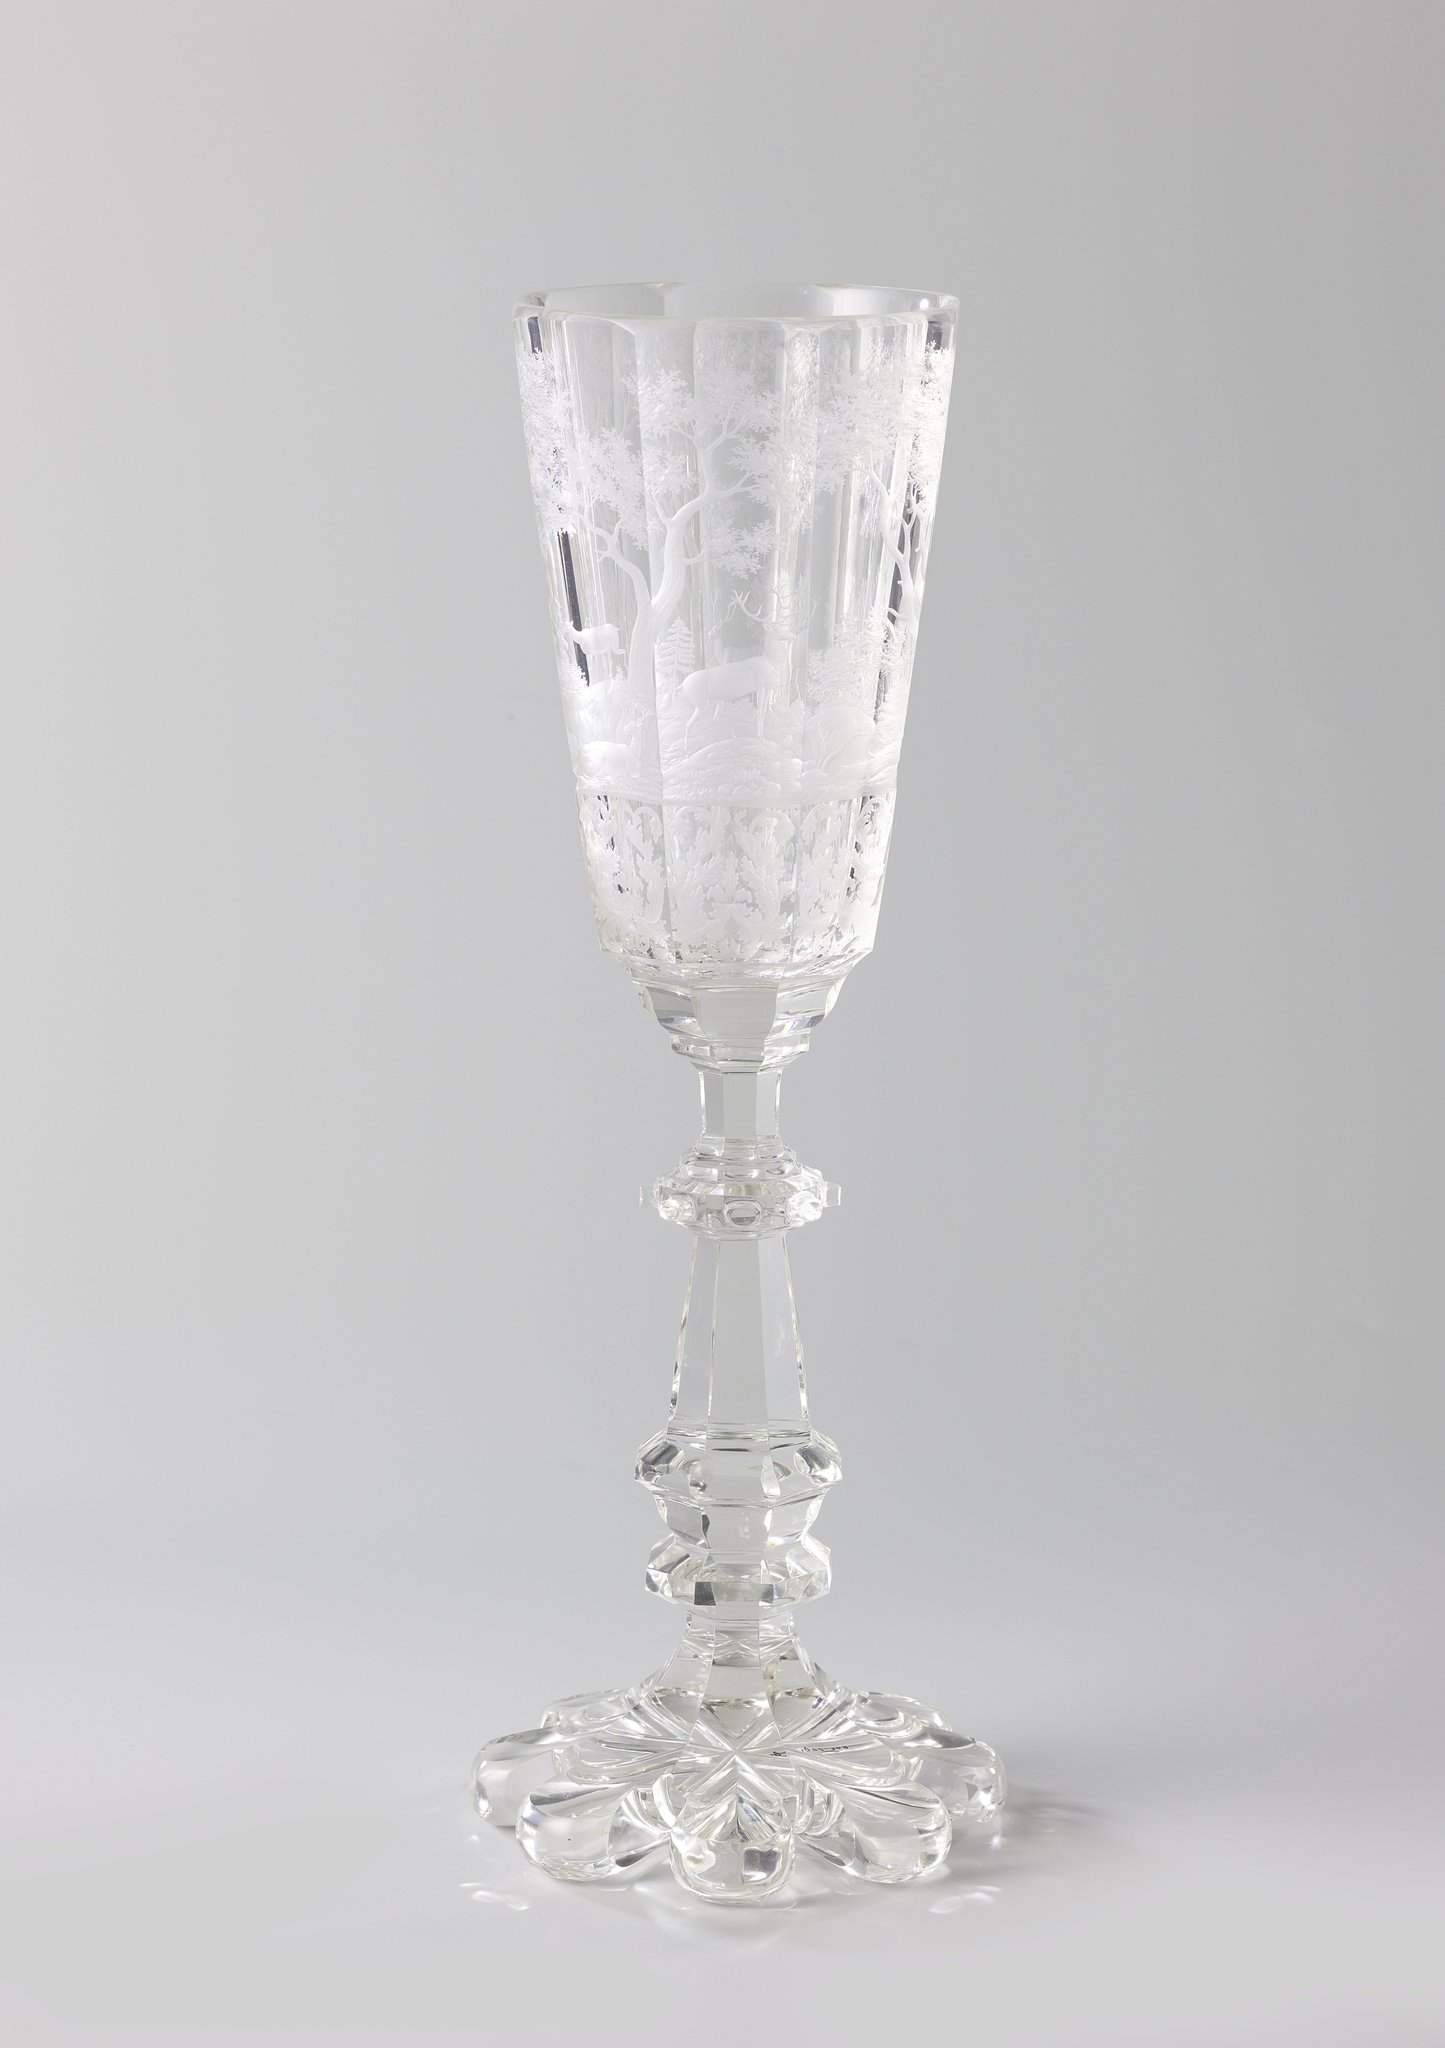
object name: goblet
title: Bokaal met een boslandschap met herten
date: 1850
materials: glass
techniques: glassblowing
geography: bohemia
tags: stag-hunting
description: Goblet. Glass, wheel engraving. Bohemia, c. 1850, attributed to August Böhm.